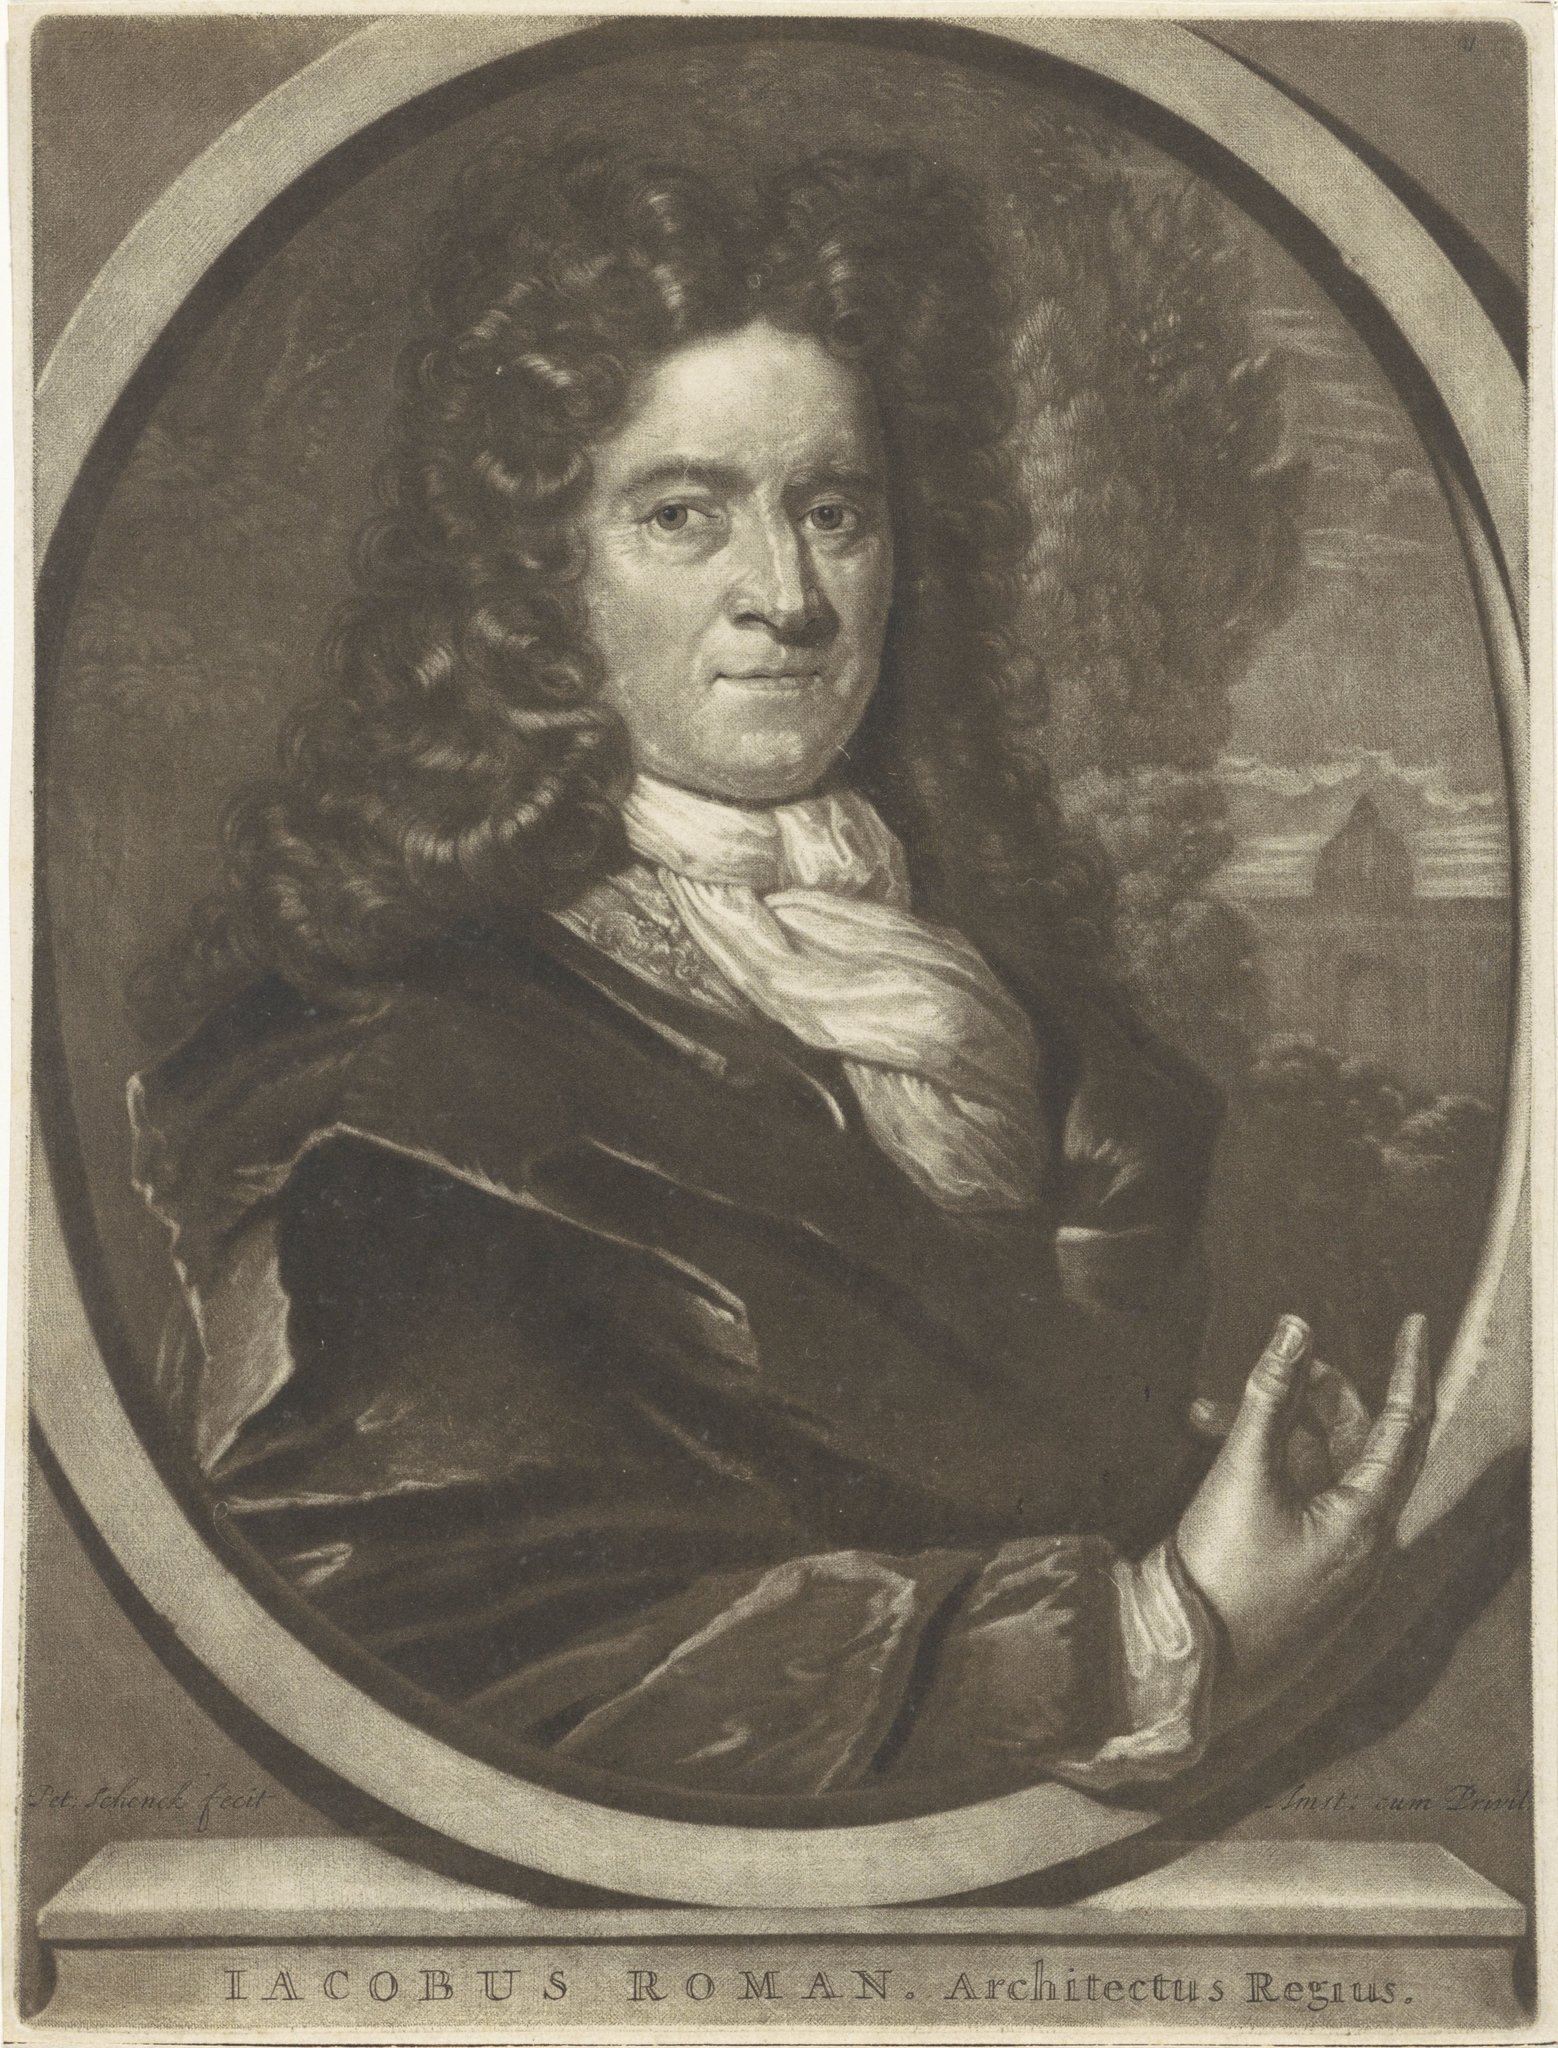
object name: print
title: Portret van Jacob Pietersz. Roman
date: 1670-1713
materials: paper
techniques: engraving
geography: amsterdam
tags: the hague, garden, wig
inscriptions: collector's mark: Lugt 964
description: De beeldhouwer en architect Jacob Pietersz. Roman. Op de achtergrond een tuin en een gebouw.